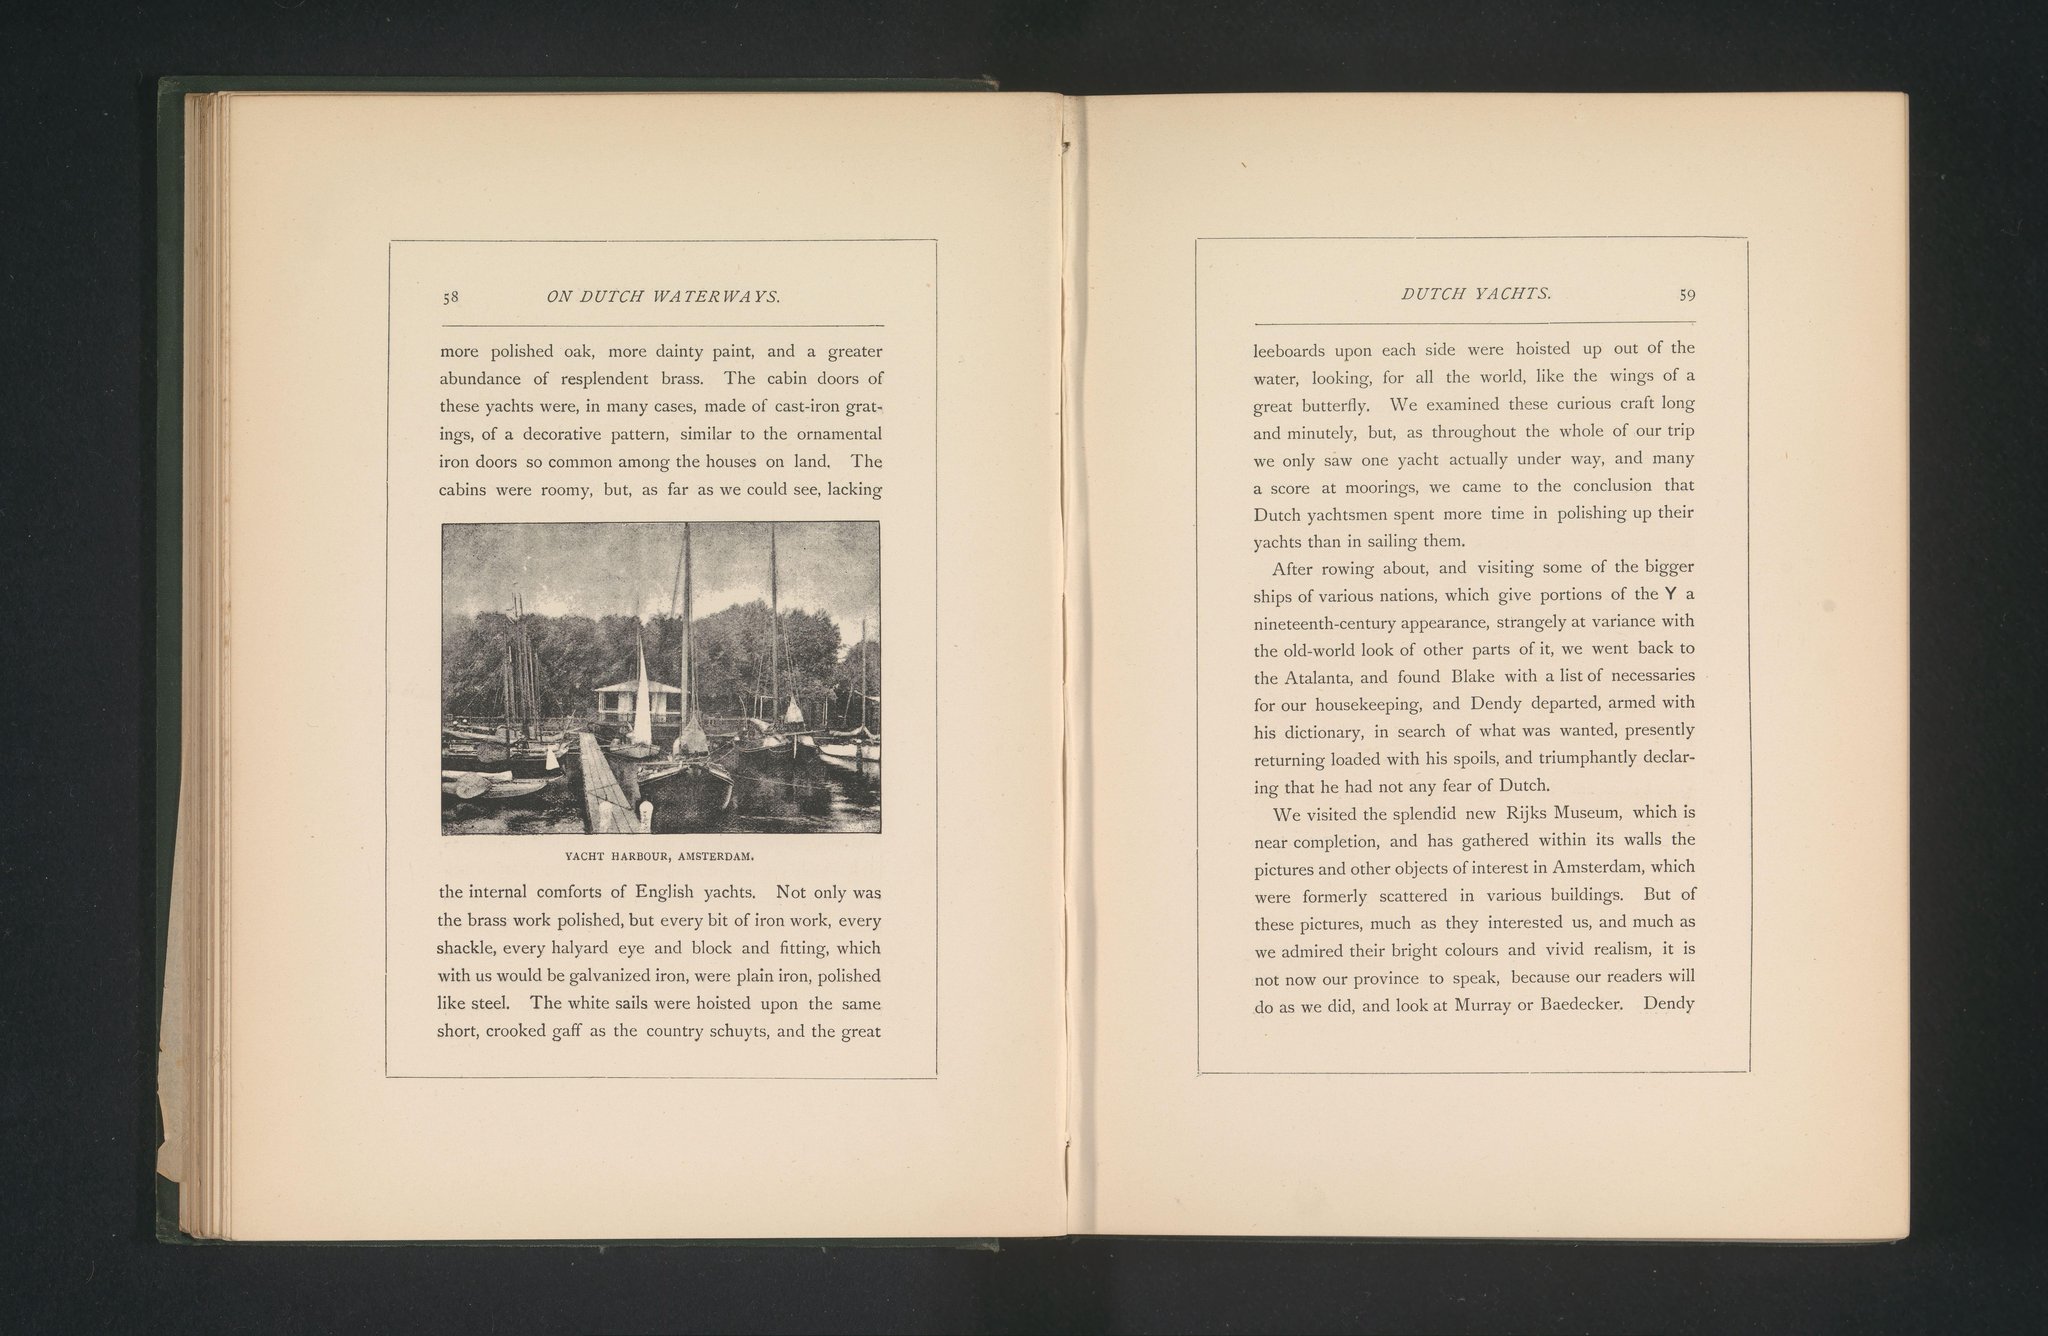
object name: page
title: Yacht Harbour, Amsterdam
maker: george christopher davies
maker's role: fotograaf, geoloog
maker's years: 1849-1922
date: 1881-1886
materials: paper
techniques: autotype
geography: london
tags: harbour, amsterdam